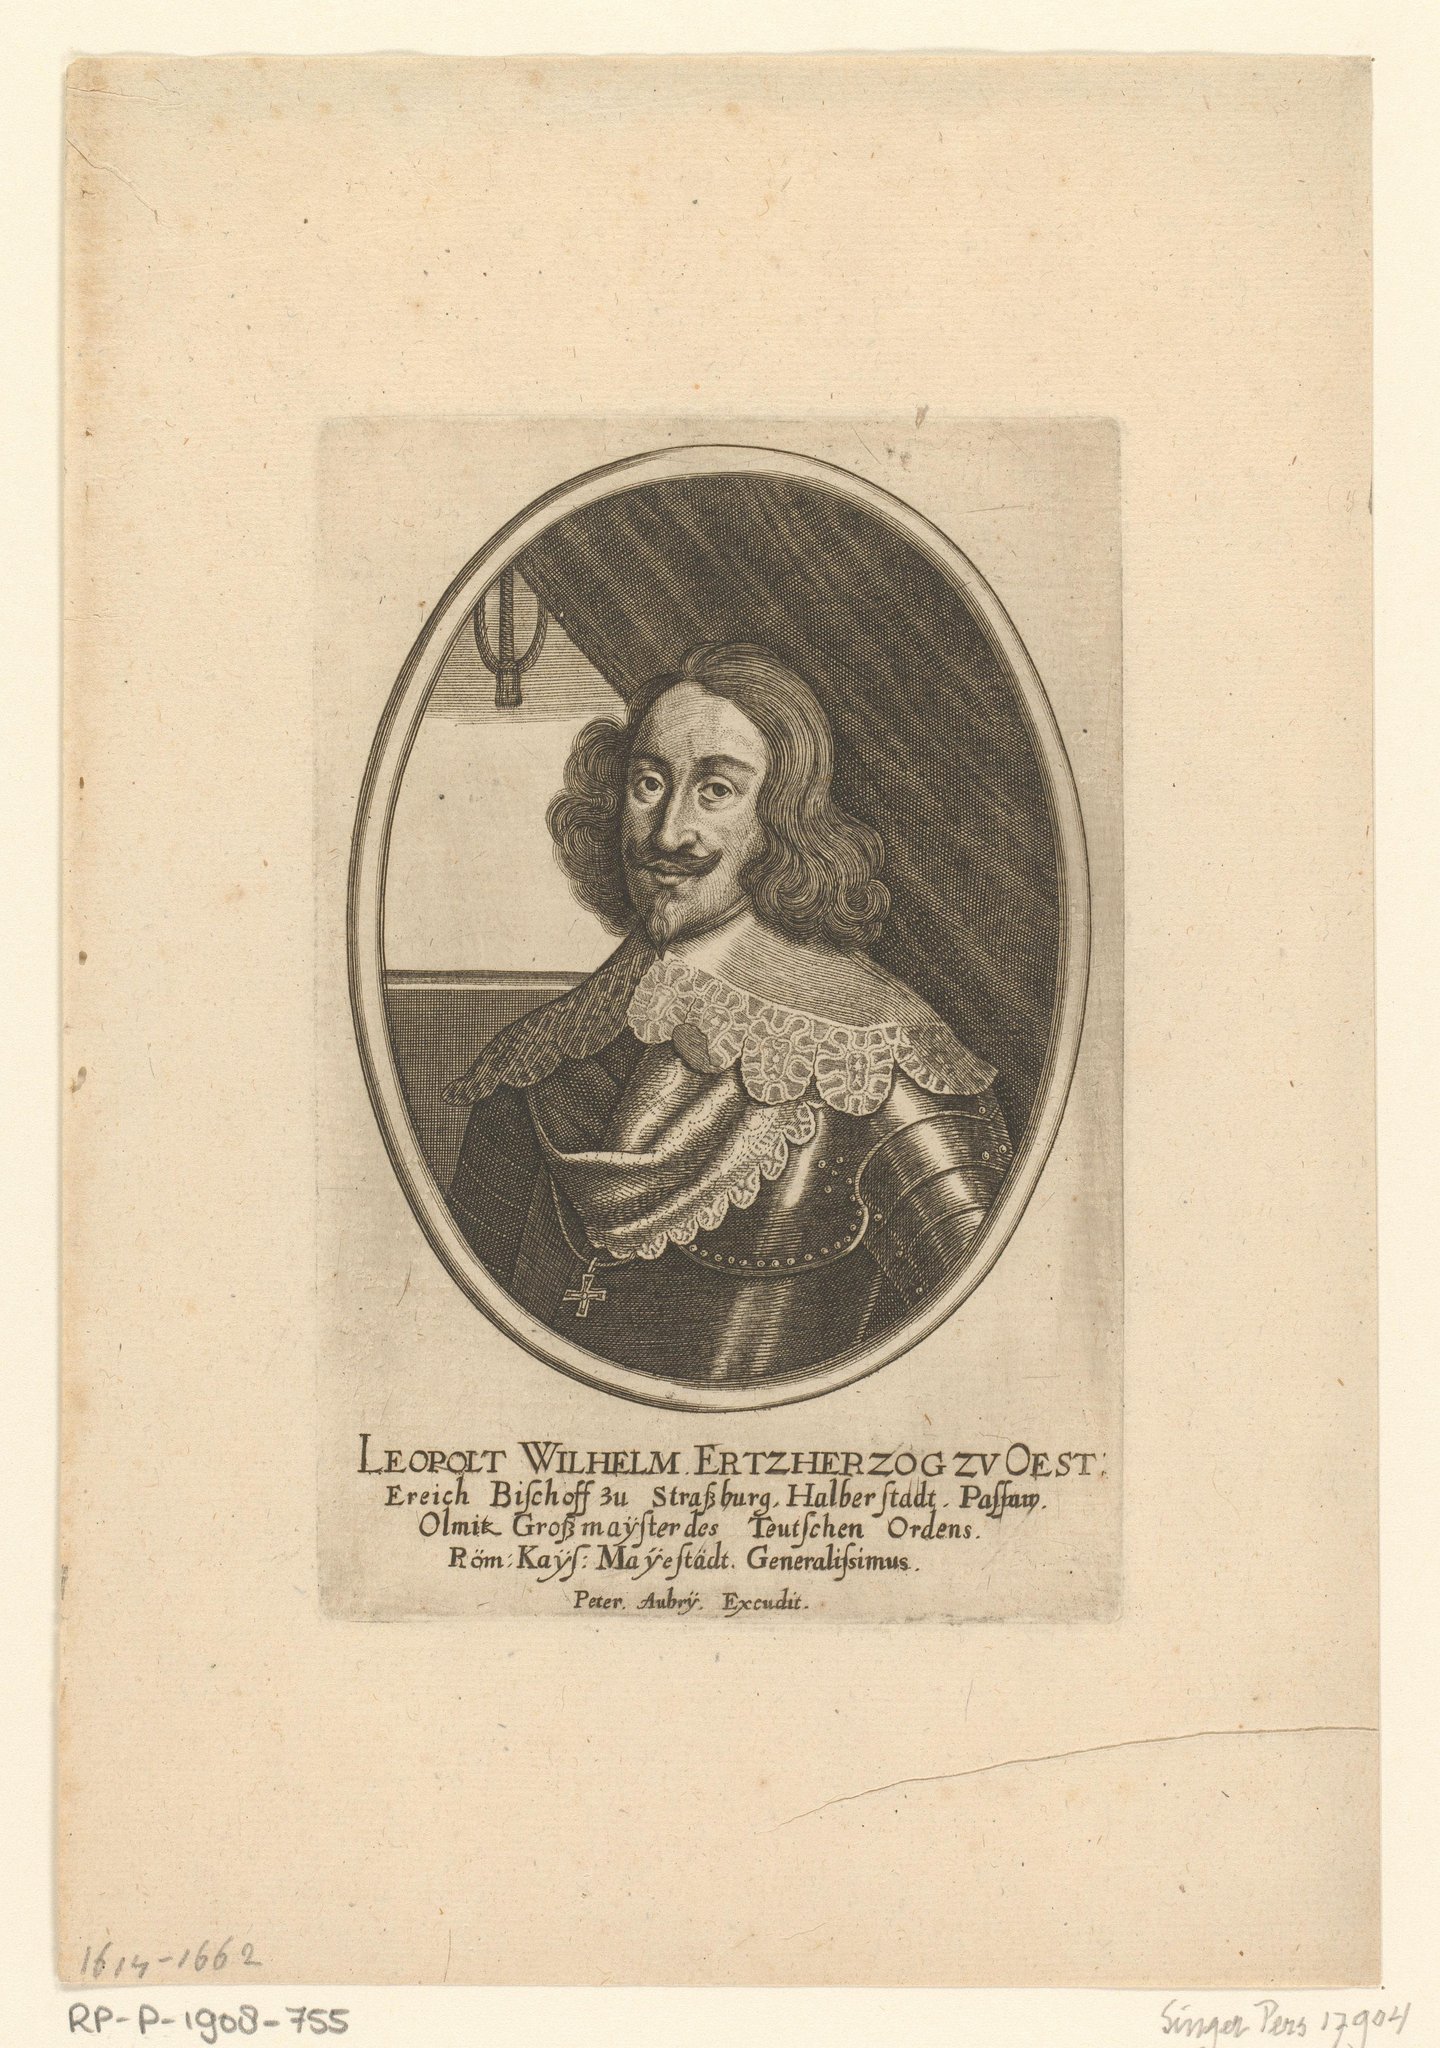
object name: print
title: Portret van Leopold Willem van Oostenrijk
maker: Anonymous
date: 1654-1686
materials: paper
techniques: engraving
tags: vienna, leopold willem van oostenrijk (landvoogd der zuidelijke nederlanden), historical persons, ruler, sovereign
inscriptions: collector's mark: Lugt 2228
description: Met vierregelig onderschrift in het Duits.